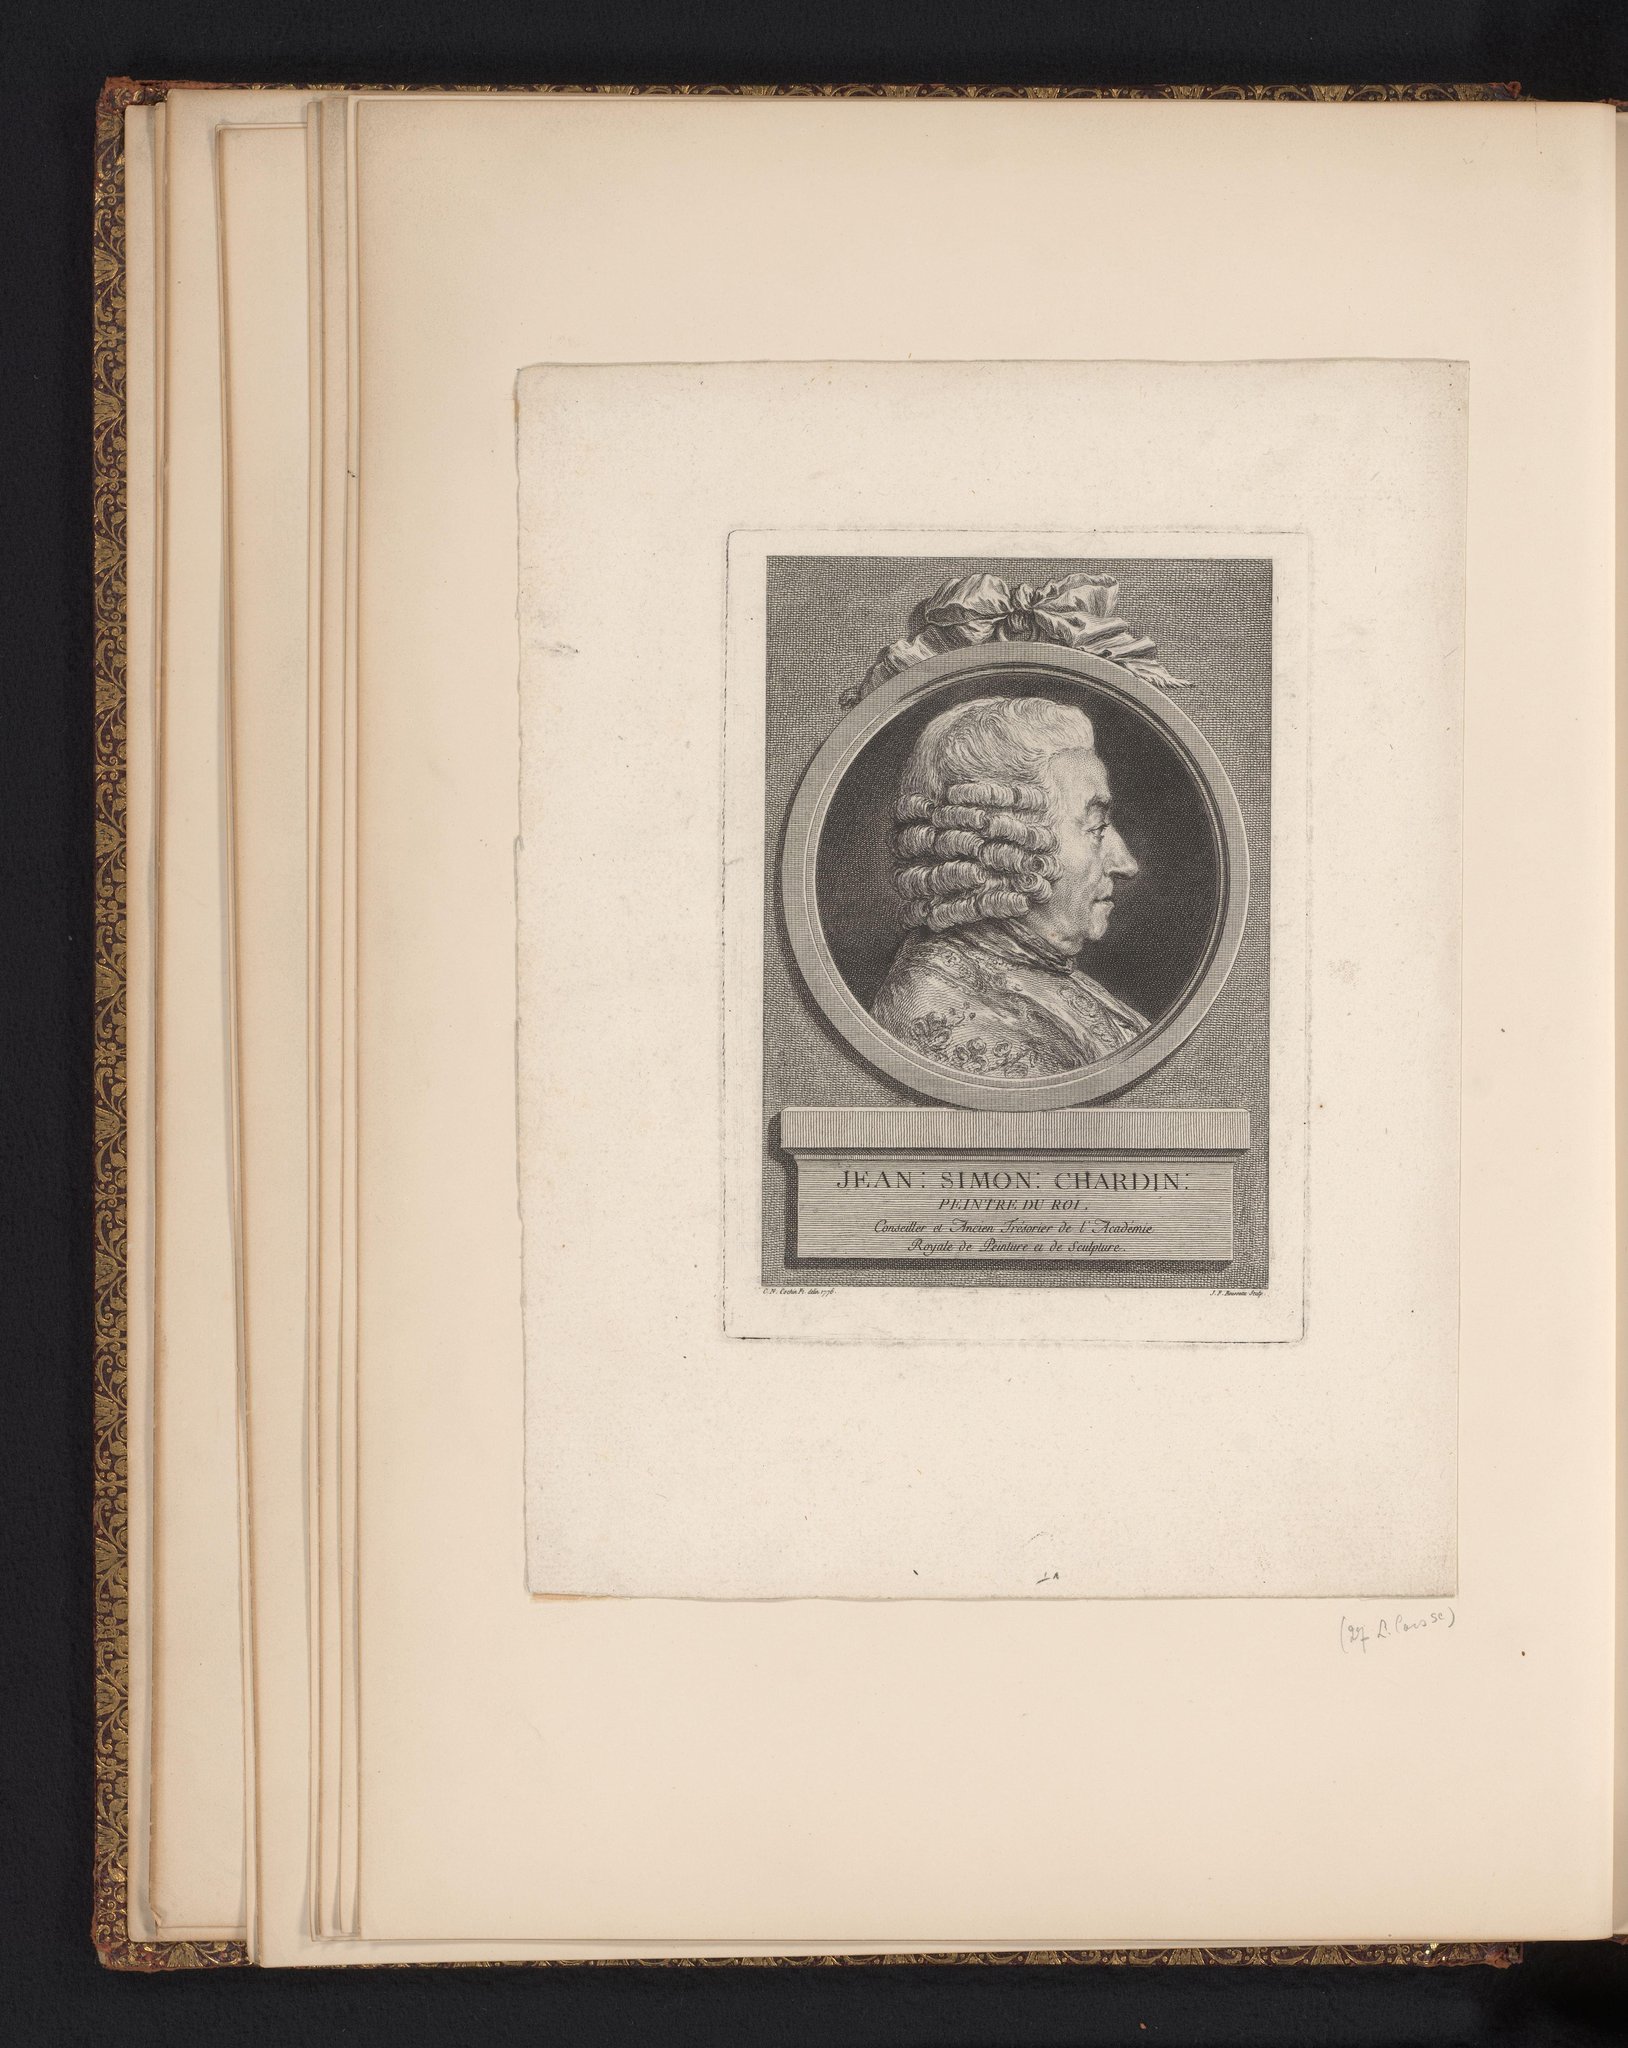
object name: album leaf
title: Jean Simon Chardin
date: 1776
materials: paper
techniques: engraving, etching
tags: jean baptiste siméon chardin, historical persons, portrait, self-portrait of graphic artist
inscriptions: date